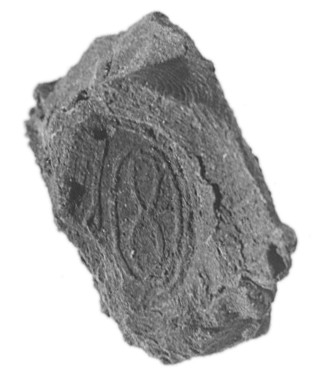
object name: sealing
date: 2030-1640 BCE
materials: clay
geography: egypt